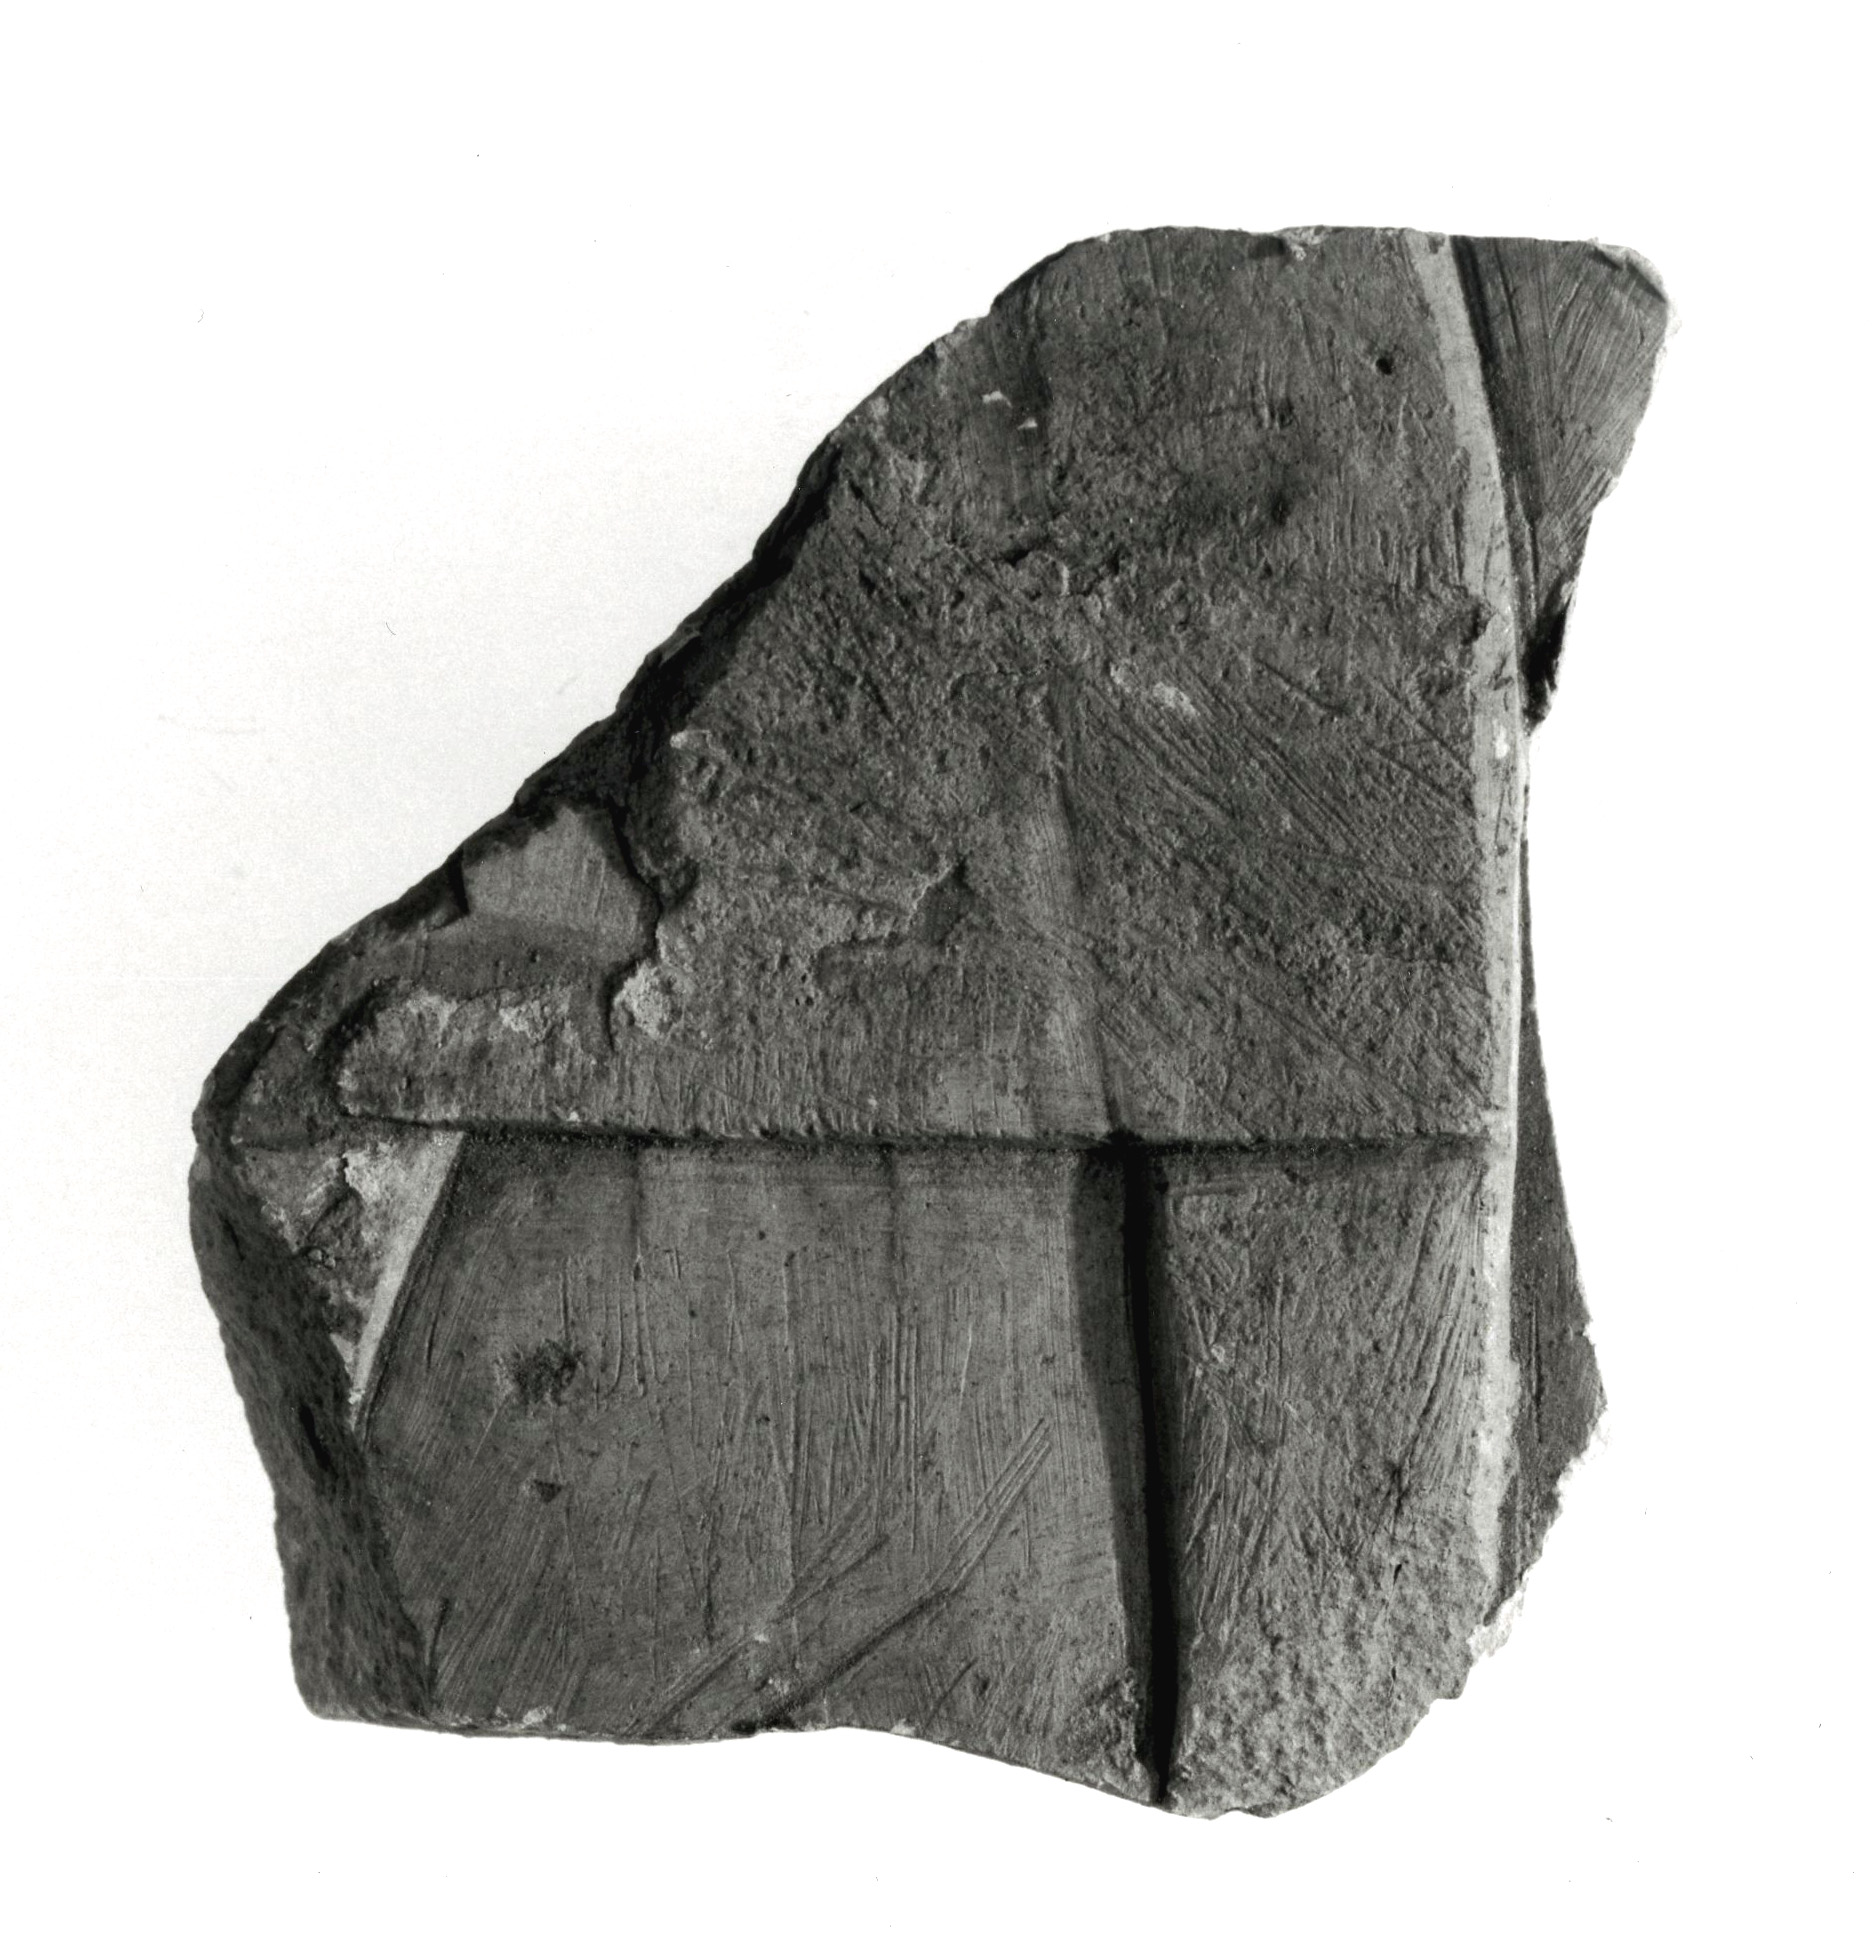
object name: relief, tomb of nespekashuty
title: Raised relief fragment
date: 664-610 BCE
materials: limestone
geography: egypt